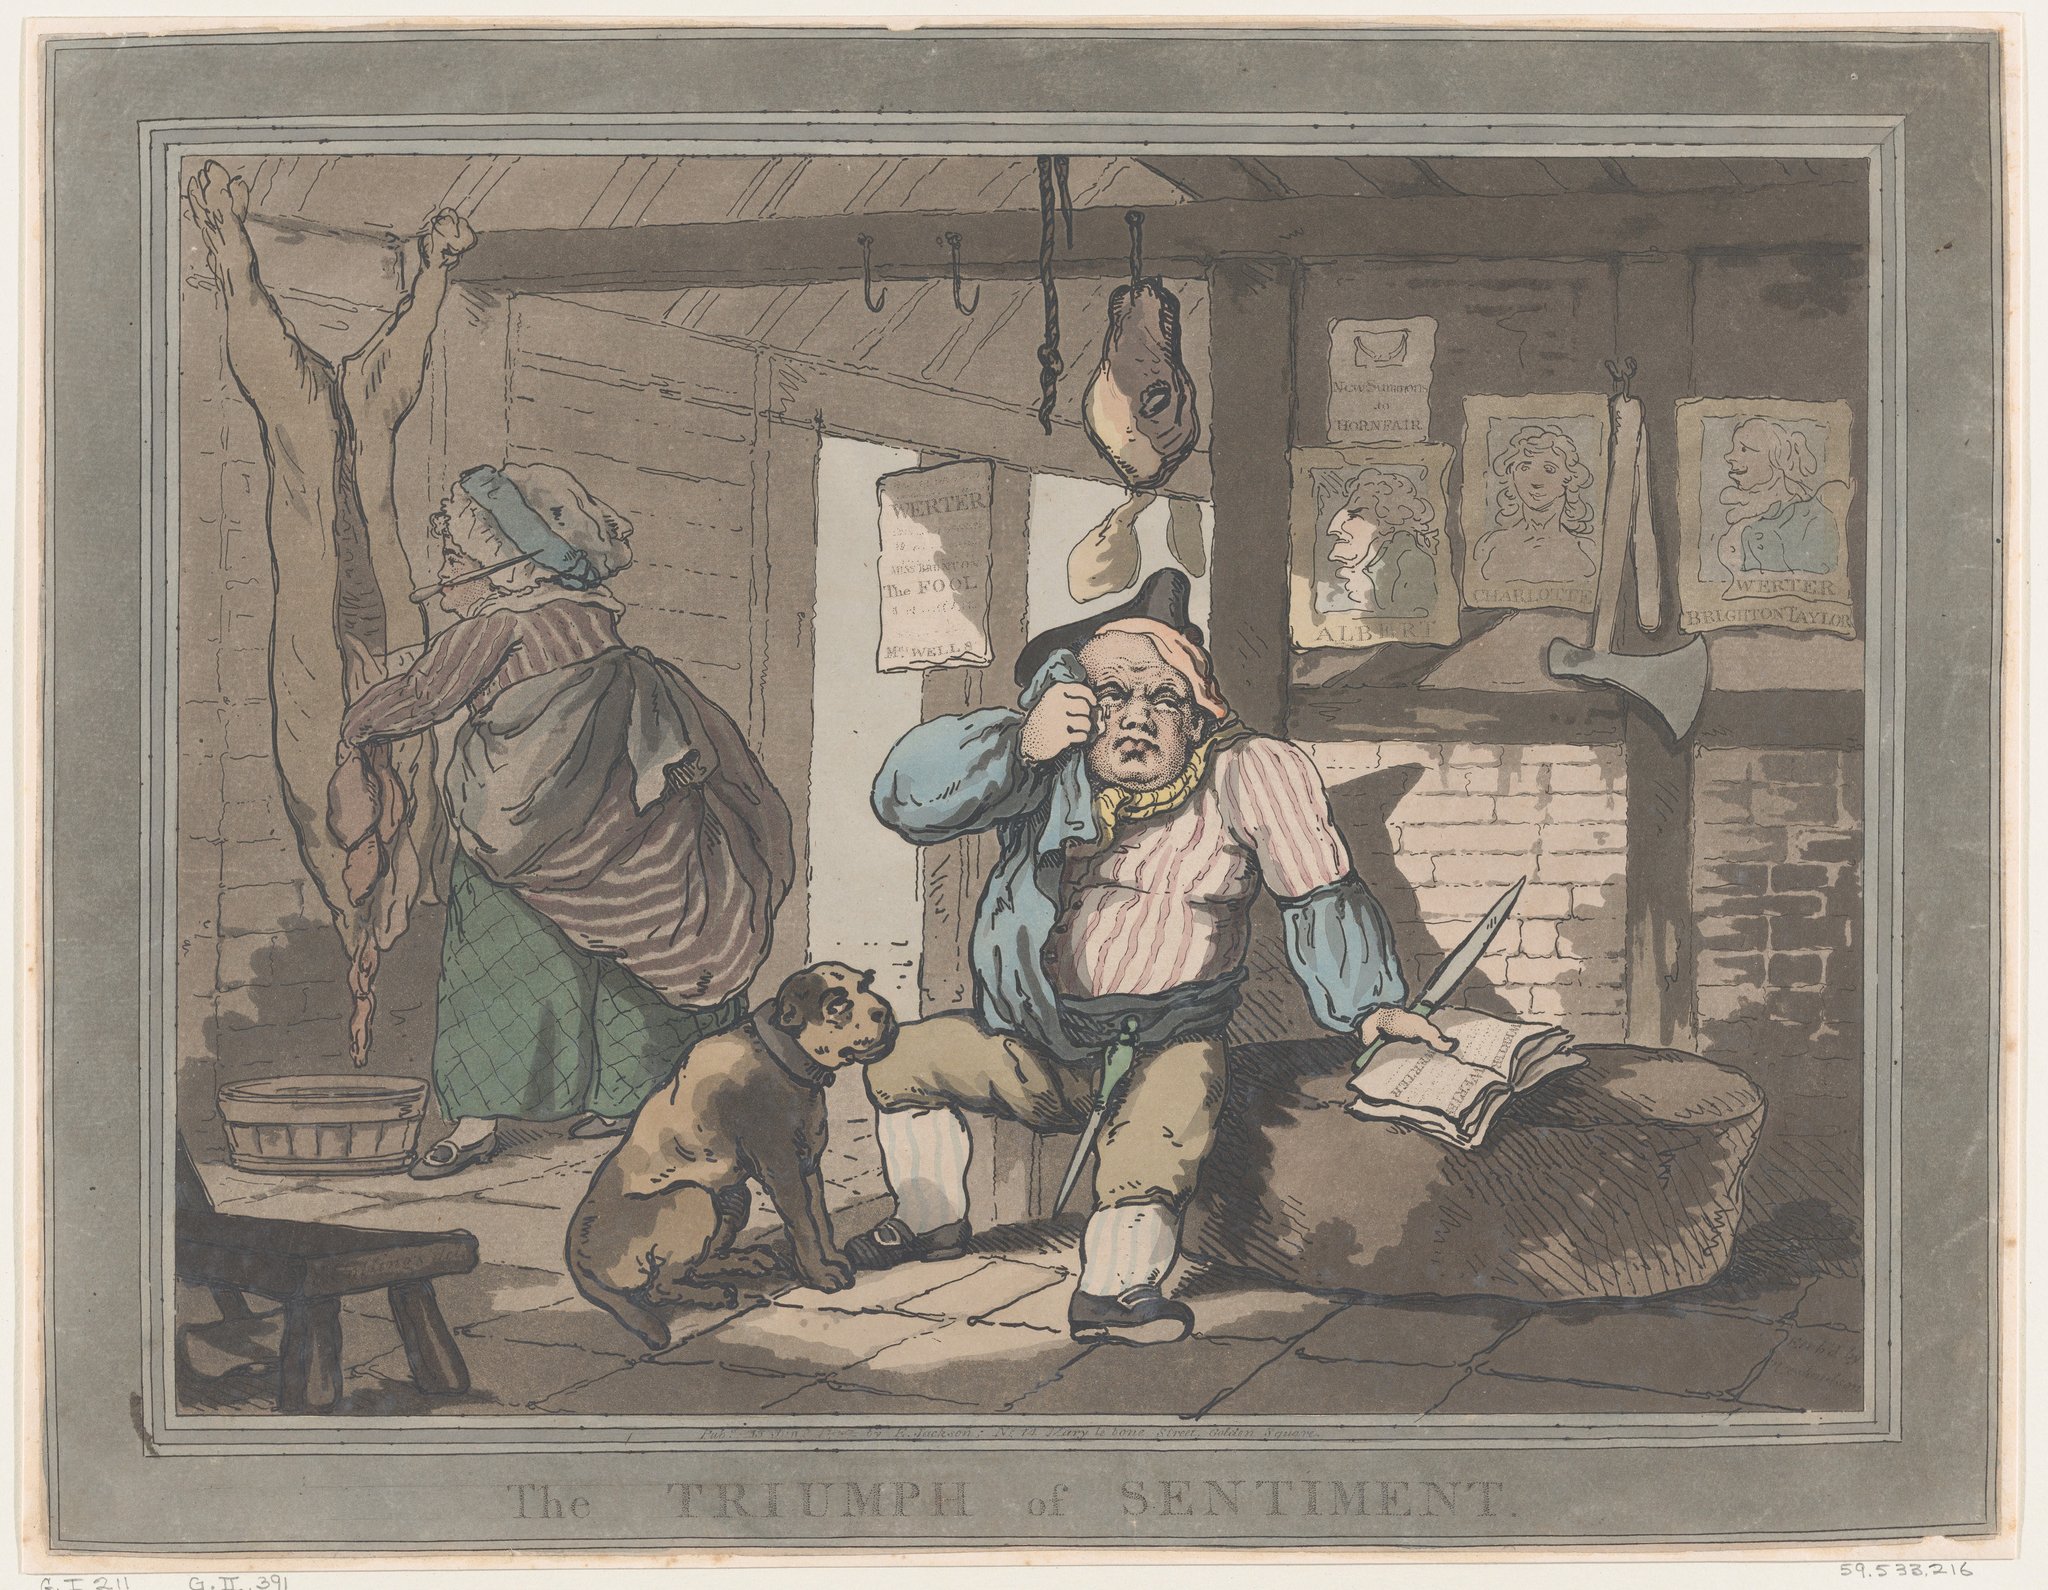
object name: print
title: The Triumph of Sentiment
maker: thomas rowlandson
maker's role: artist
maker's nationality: british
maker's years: 1757-1827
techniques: aquatint, etching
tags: men,women,dogs,axes